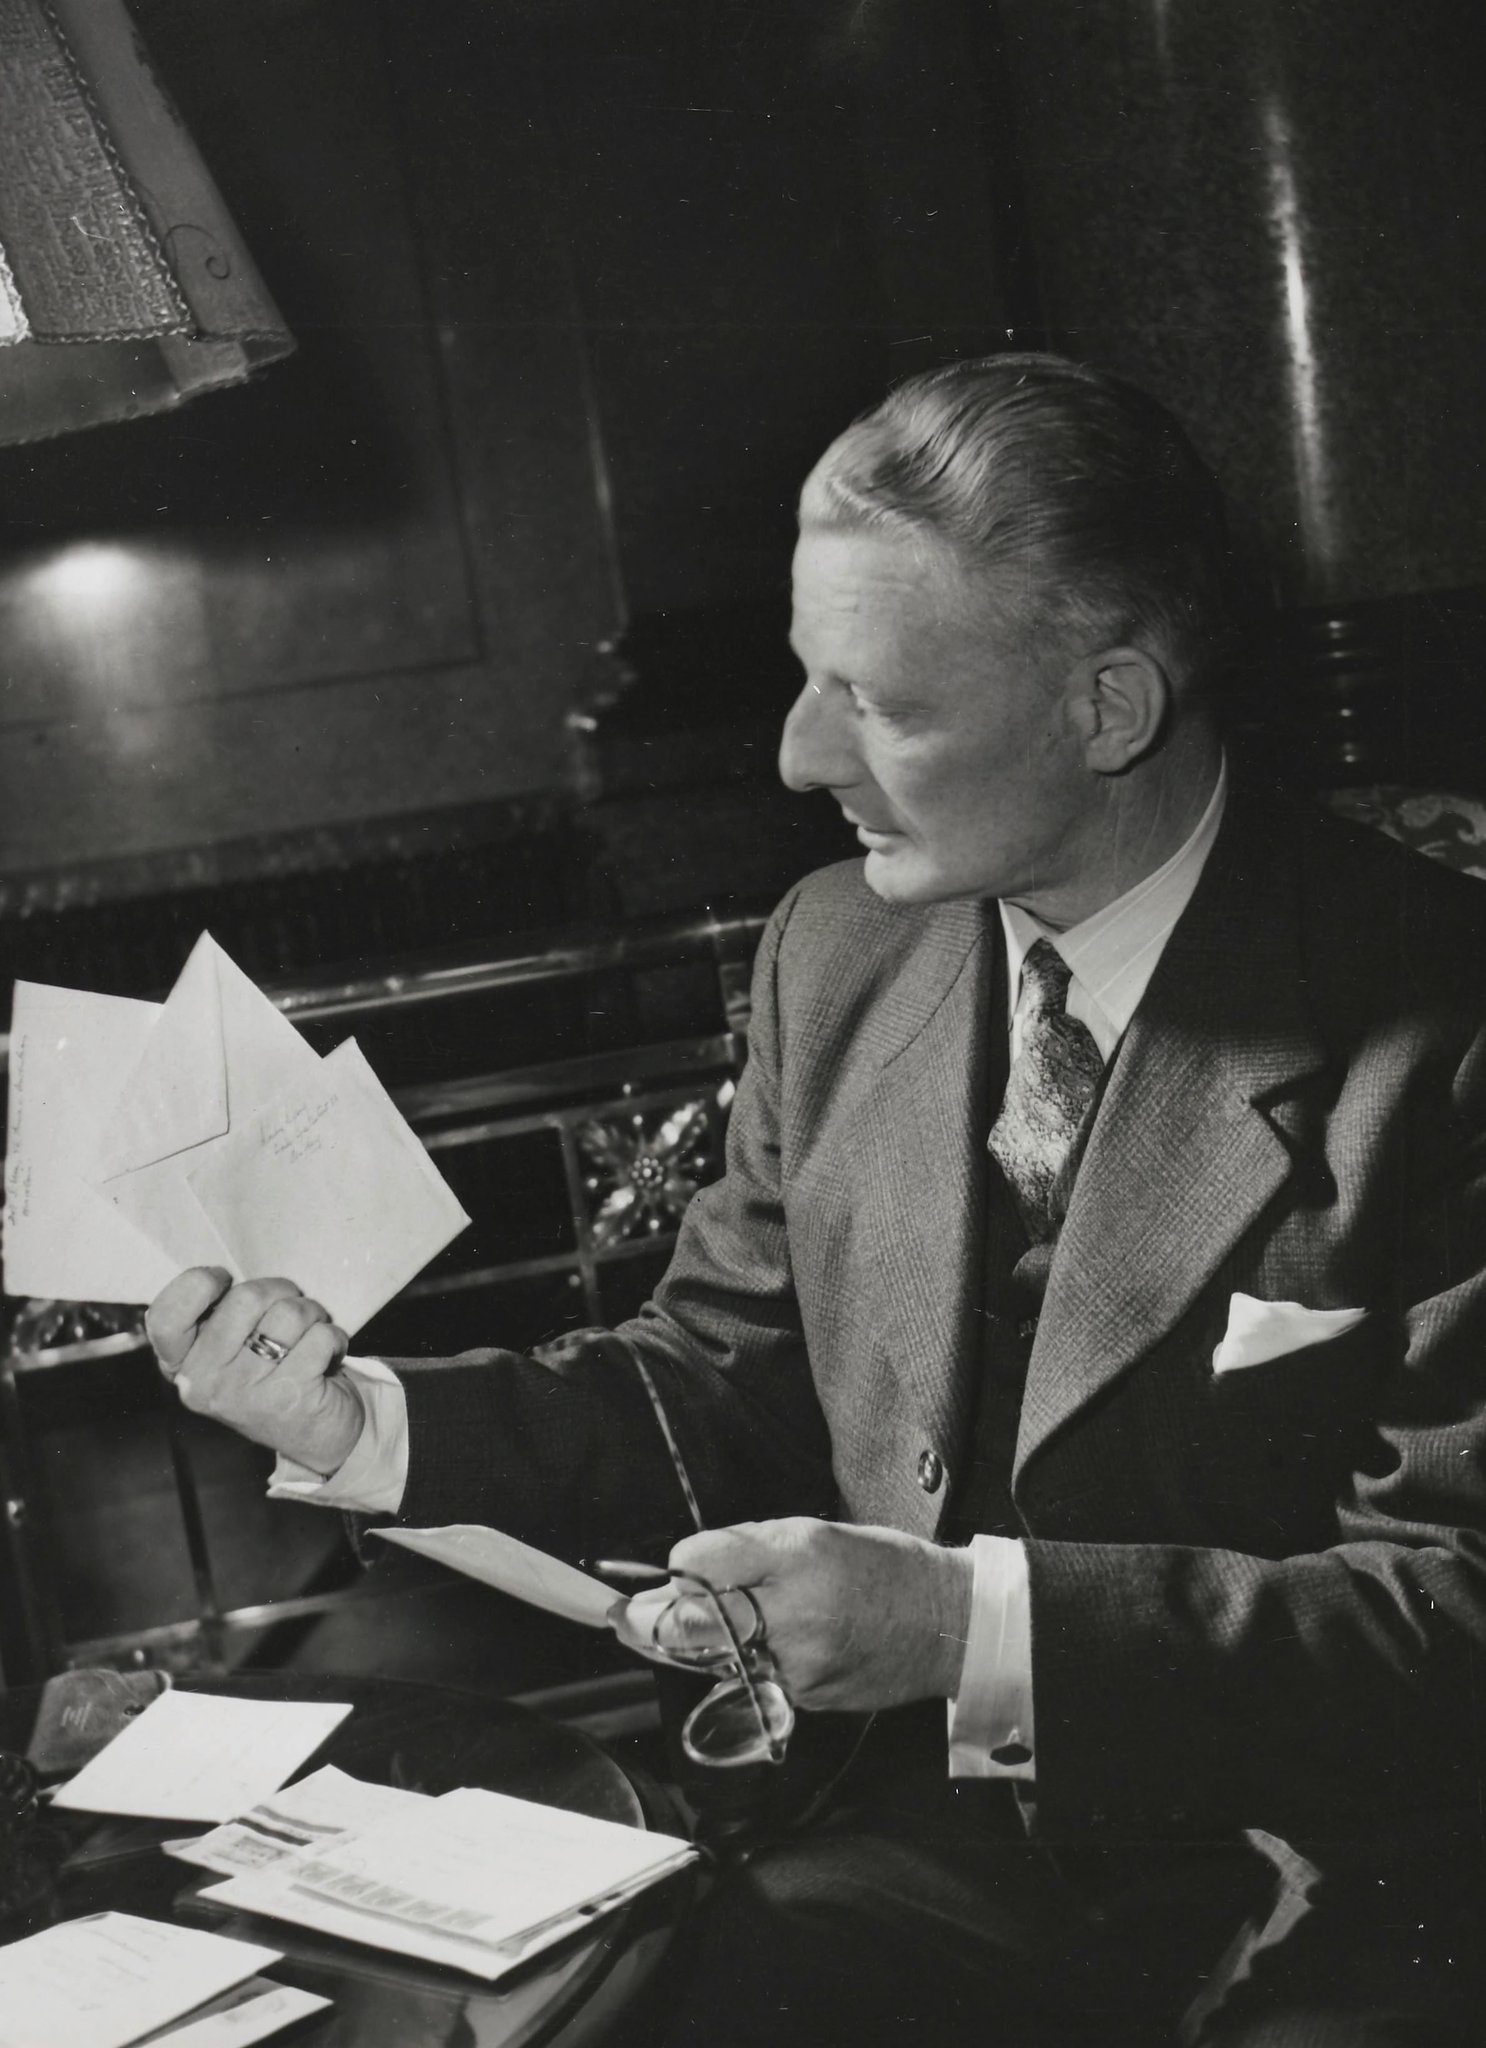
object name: documentary photograph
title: Surinamers in Nederland: 29 foto's uit het archief van Ons Vrije Nederland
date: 1902-1948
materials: photographic support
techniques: photography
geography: the hague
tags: netherlands, suriname, the hague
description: Een van de deelnemers namens Suriname aan de Ronde Tafel Conferentie tussen Nederland en de West: de heer J.A.E. Buiskool, voorzitter van de Surinaamse delegatie, zittend aan een bureau. Hij is president van het Surinaamse Hof van Justitie.